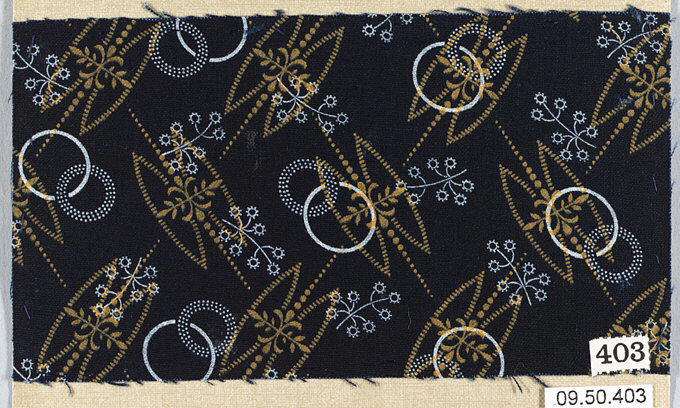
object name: piece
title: Piece (one of 116)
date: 1801-1900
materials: cotton